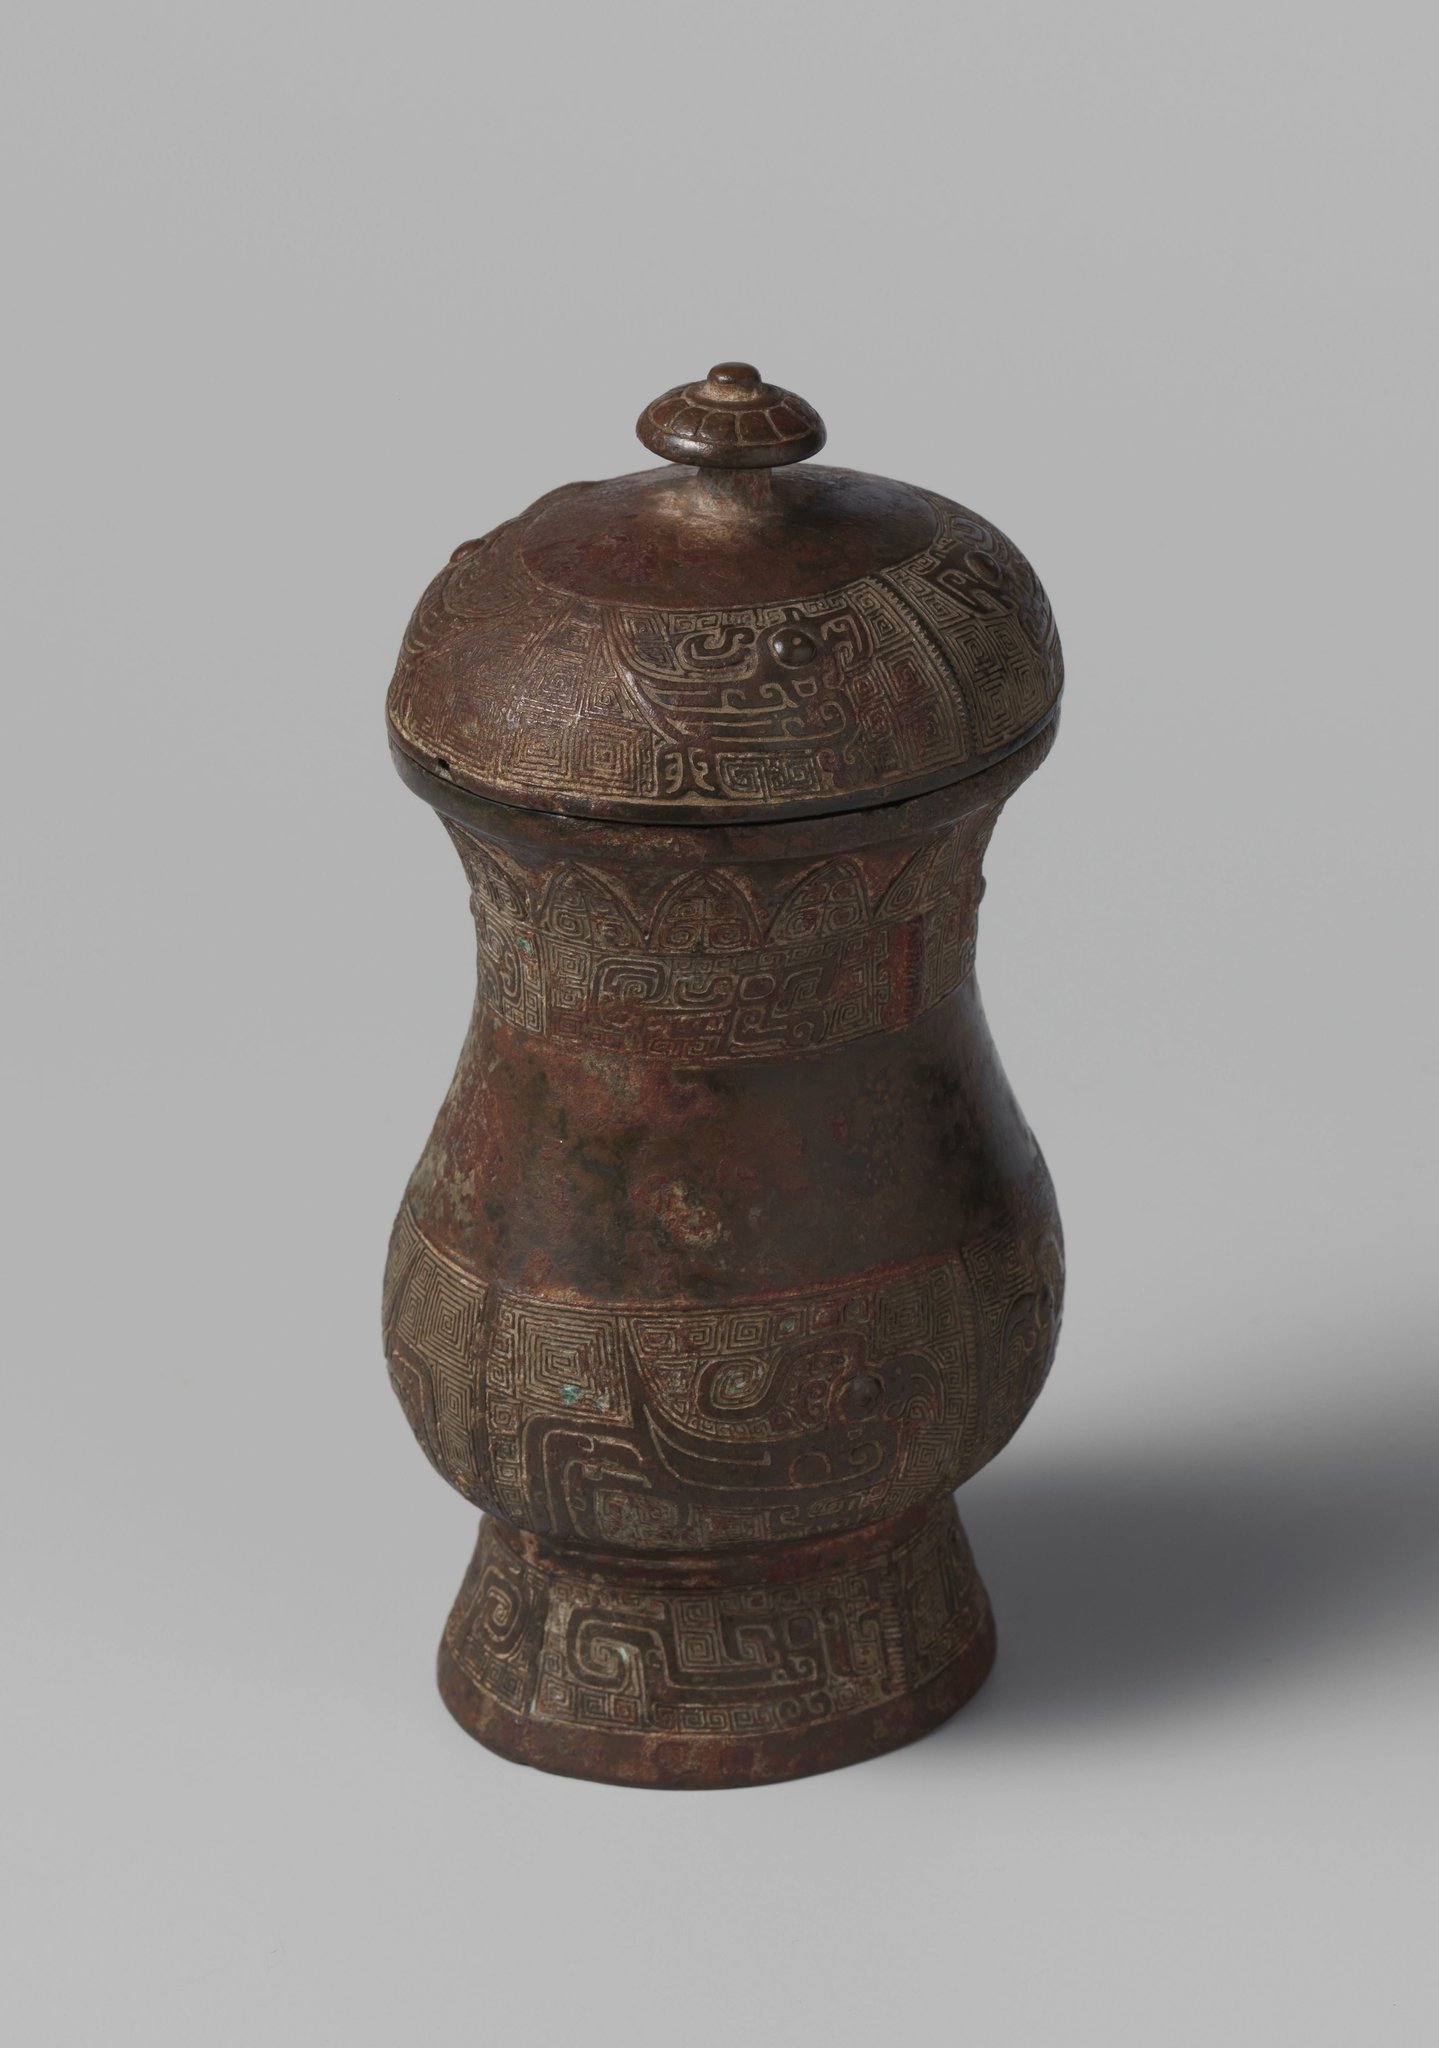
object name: wine cup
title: Ritual wine cups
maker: Anonymous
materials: bronze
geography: china